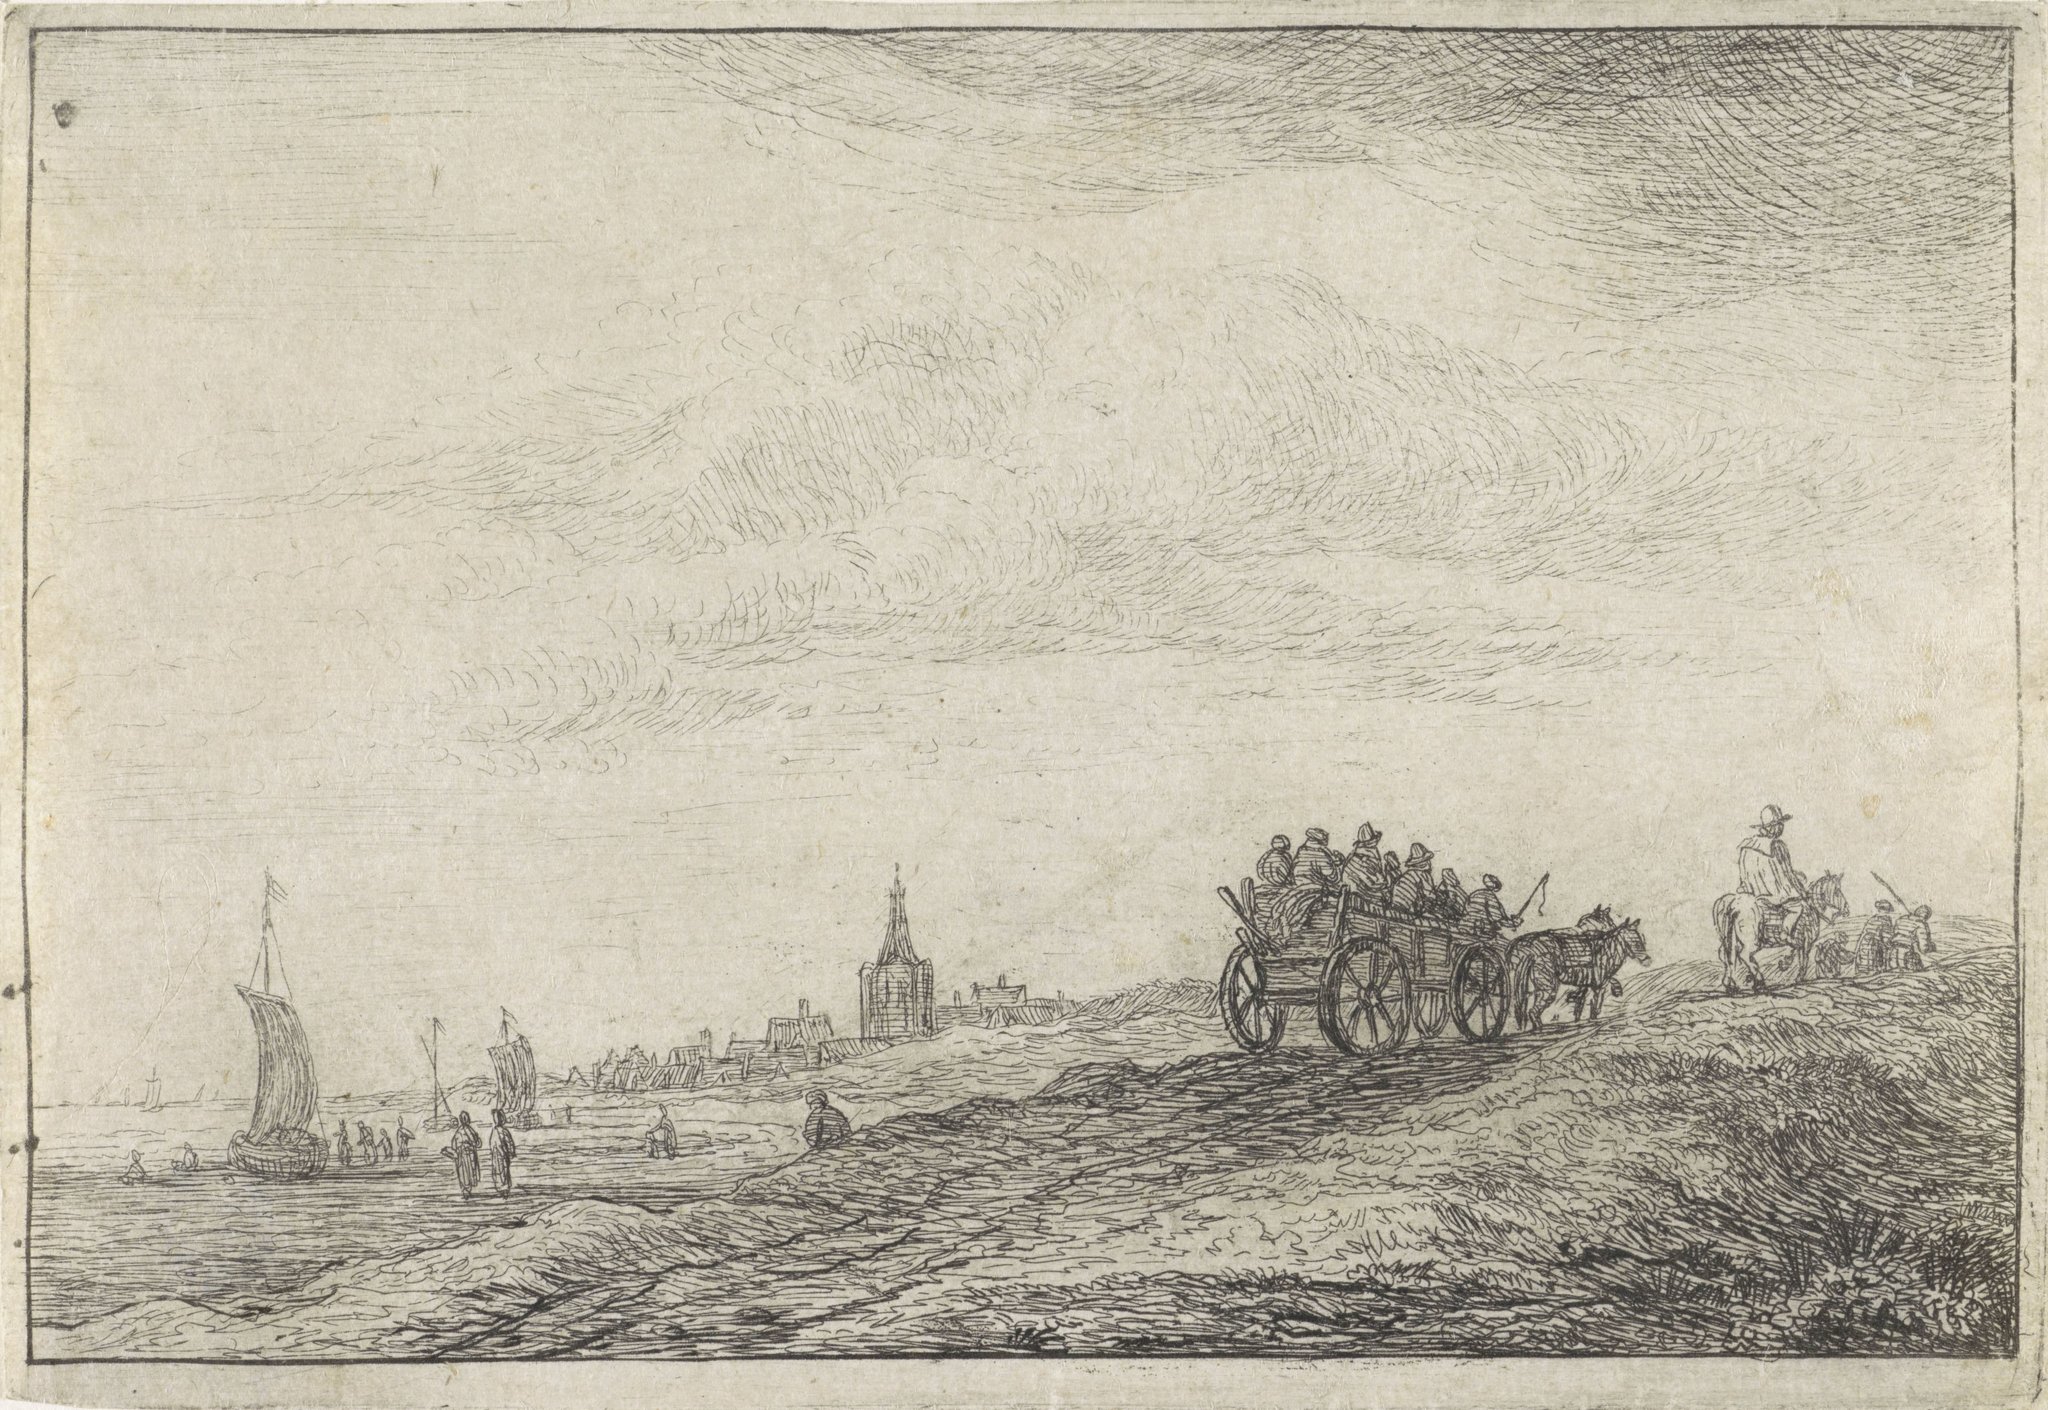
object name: print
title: Kustlijn met paard en wagen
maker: anthonie waterloo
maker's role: draughtsman, painter, print maker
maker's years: 1609-1690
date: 1630-1663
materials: paper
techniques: etching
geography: amsterdam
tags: city-view, and landscape with man-made constructions, sailing-ship, sailing-boat, horse, coast, (farm) wagon, freight wagon, cart, sea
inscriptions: stamp, collector's mark: Lugt 567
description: Links liggen enkele zeilschepen voor en op de kust, mogelijk te Scheveningen. Rechts rijdt een bemande kar met twee paarden achter een ruiter en enkele wandelaars. Links in de verte ligt een dorp of stad met een kerktoren.